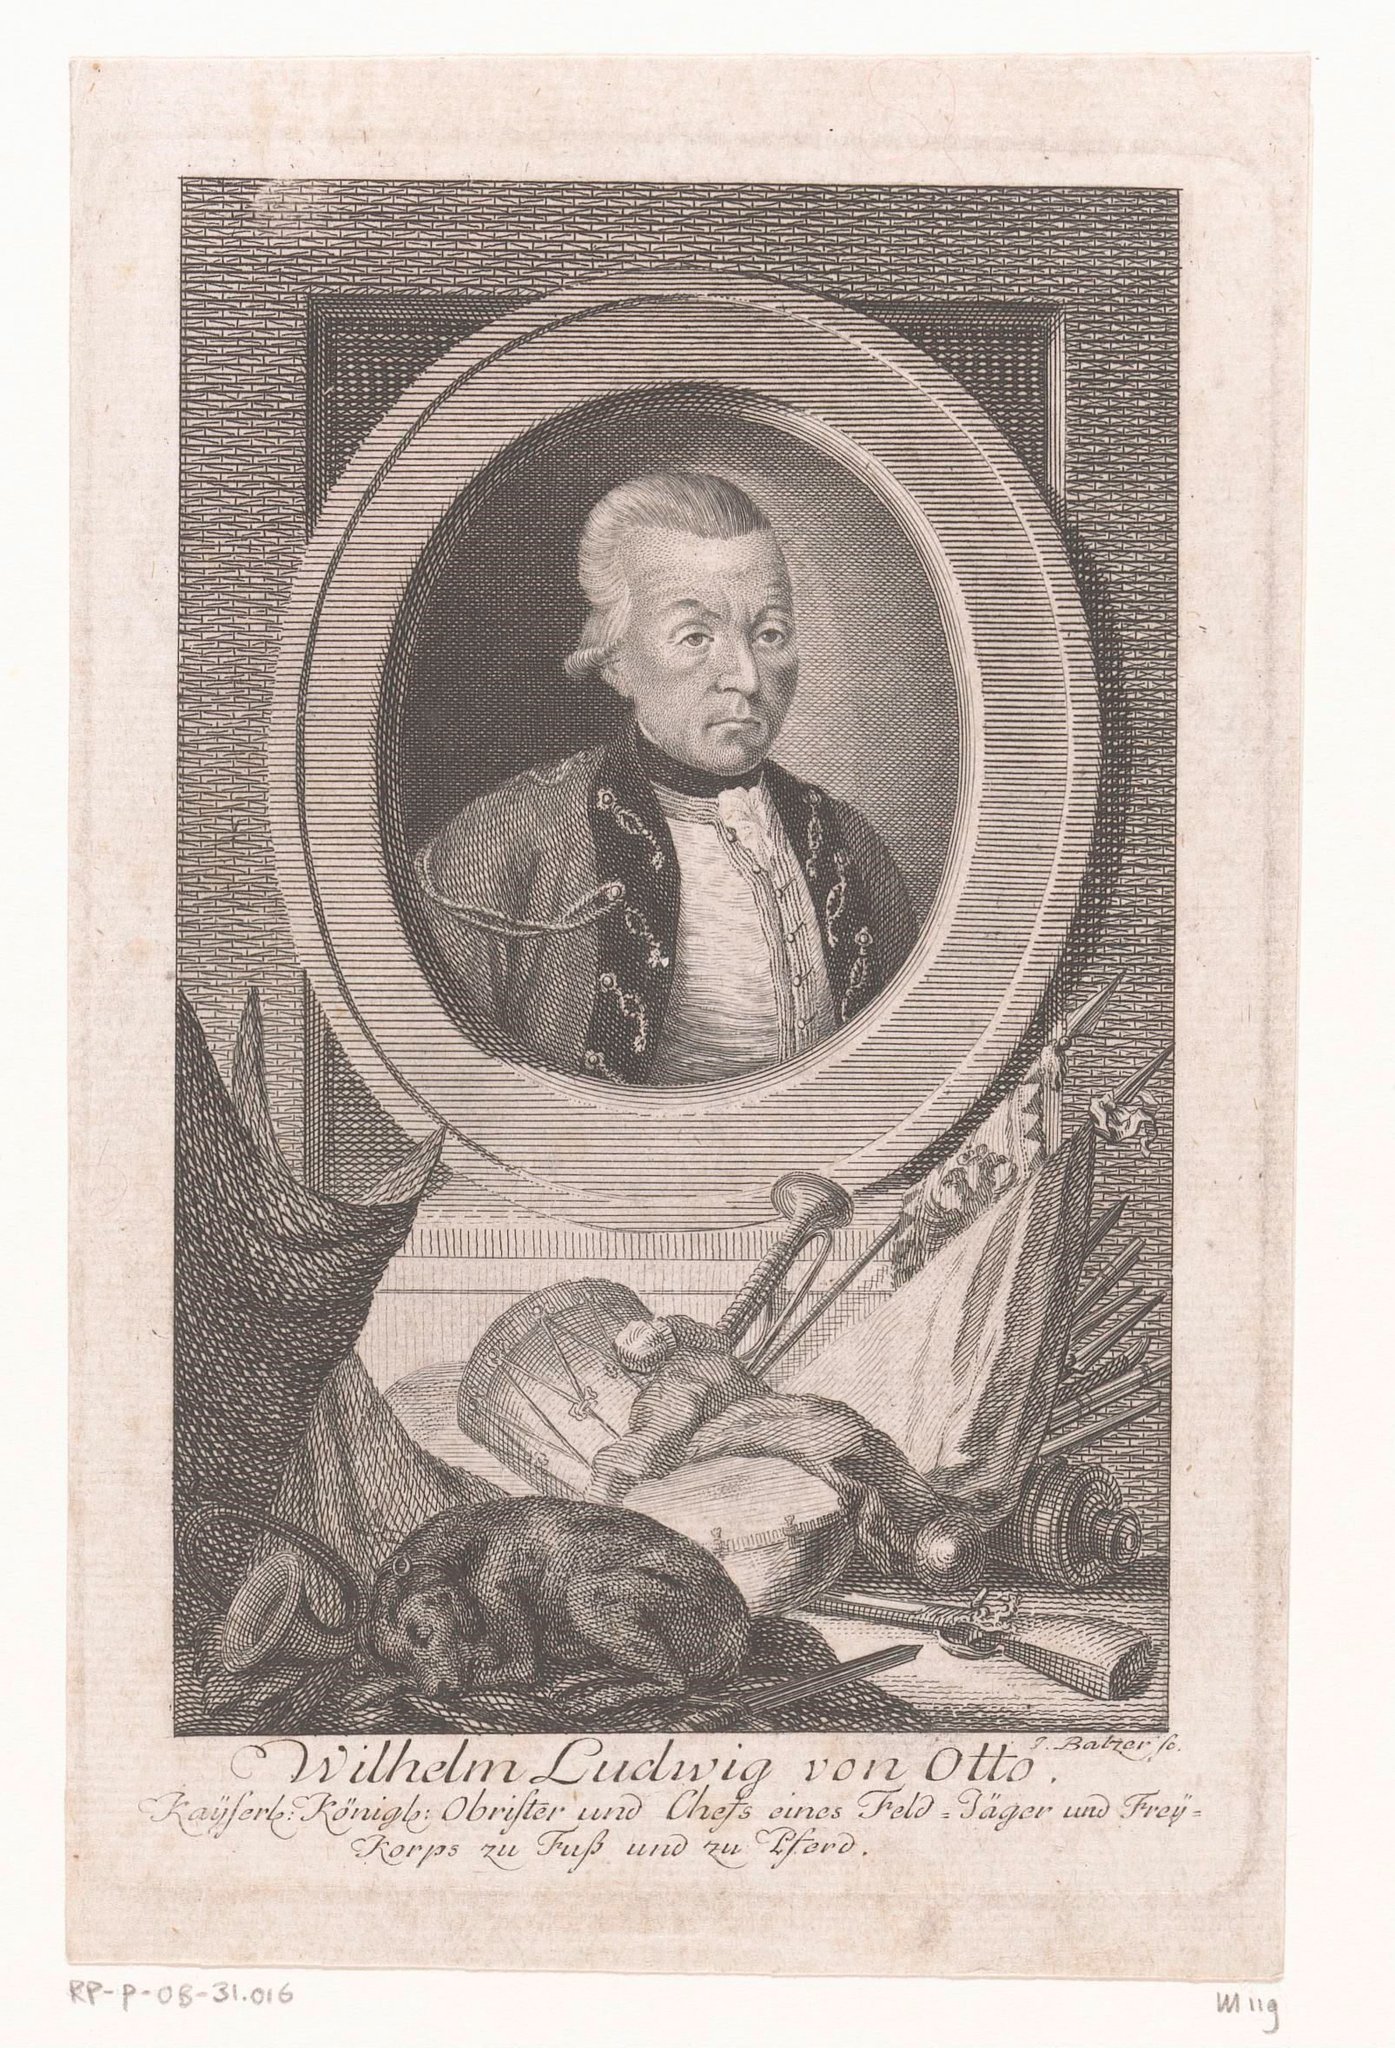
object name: print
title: Portret van Wilhelm Ludwig von Otto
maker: jan balzer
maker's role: print maker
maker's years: 1736-1799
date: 1746-1799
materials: paper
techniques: engraving, etching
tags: historical persons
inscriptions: collector's mark: Lugt 2228